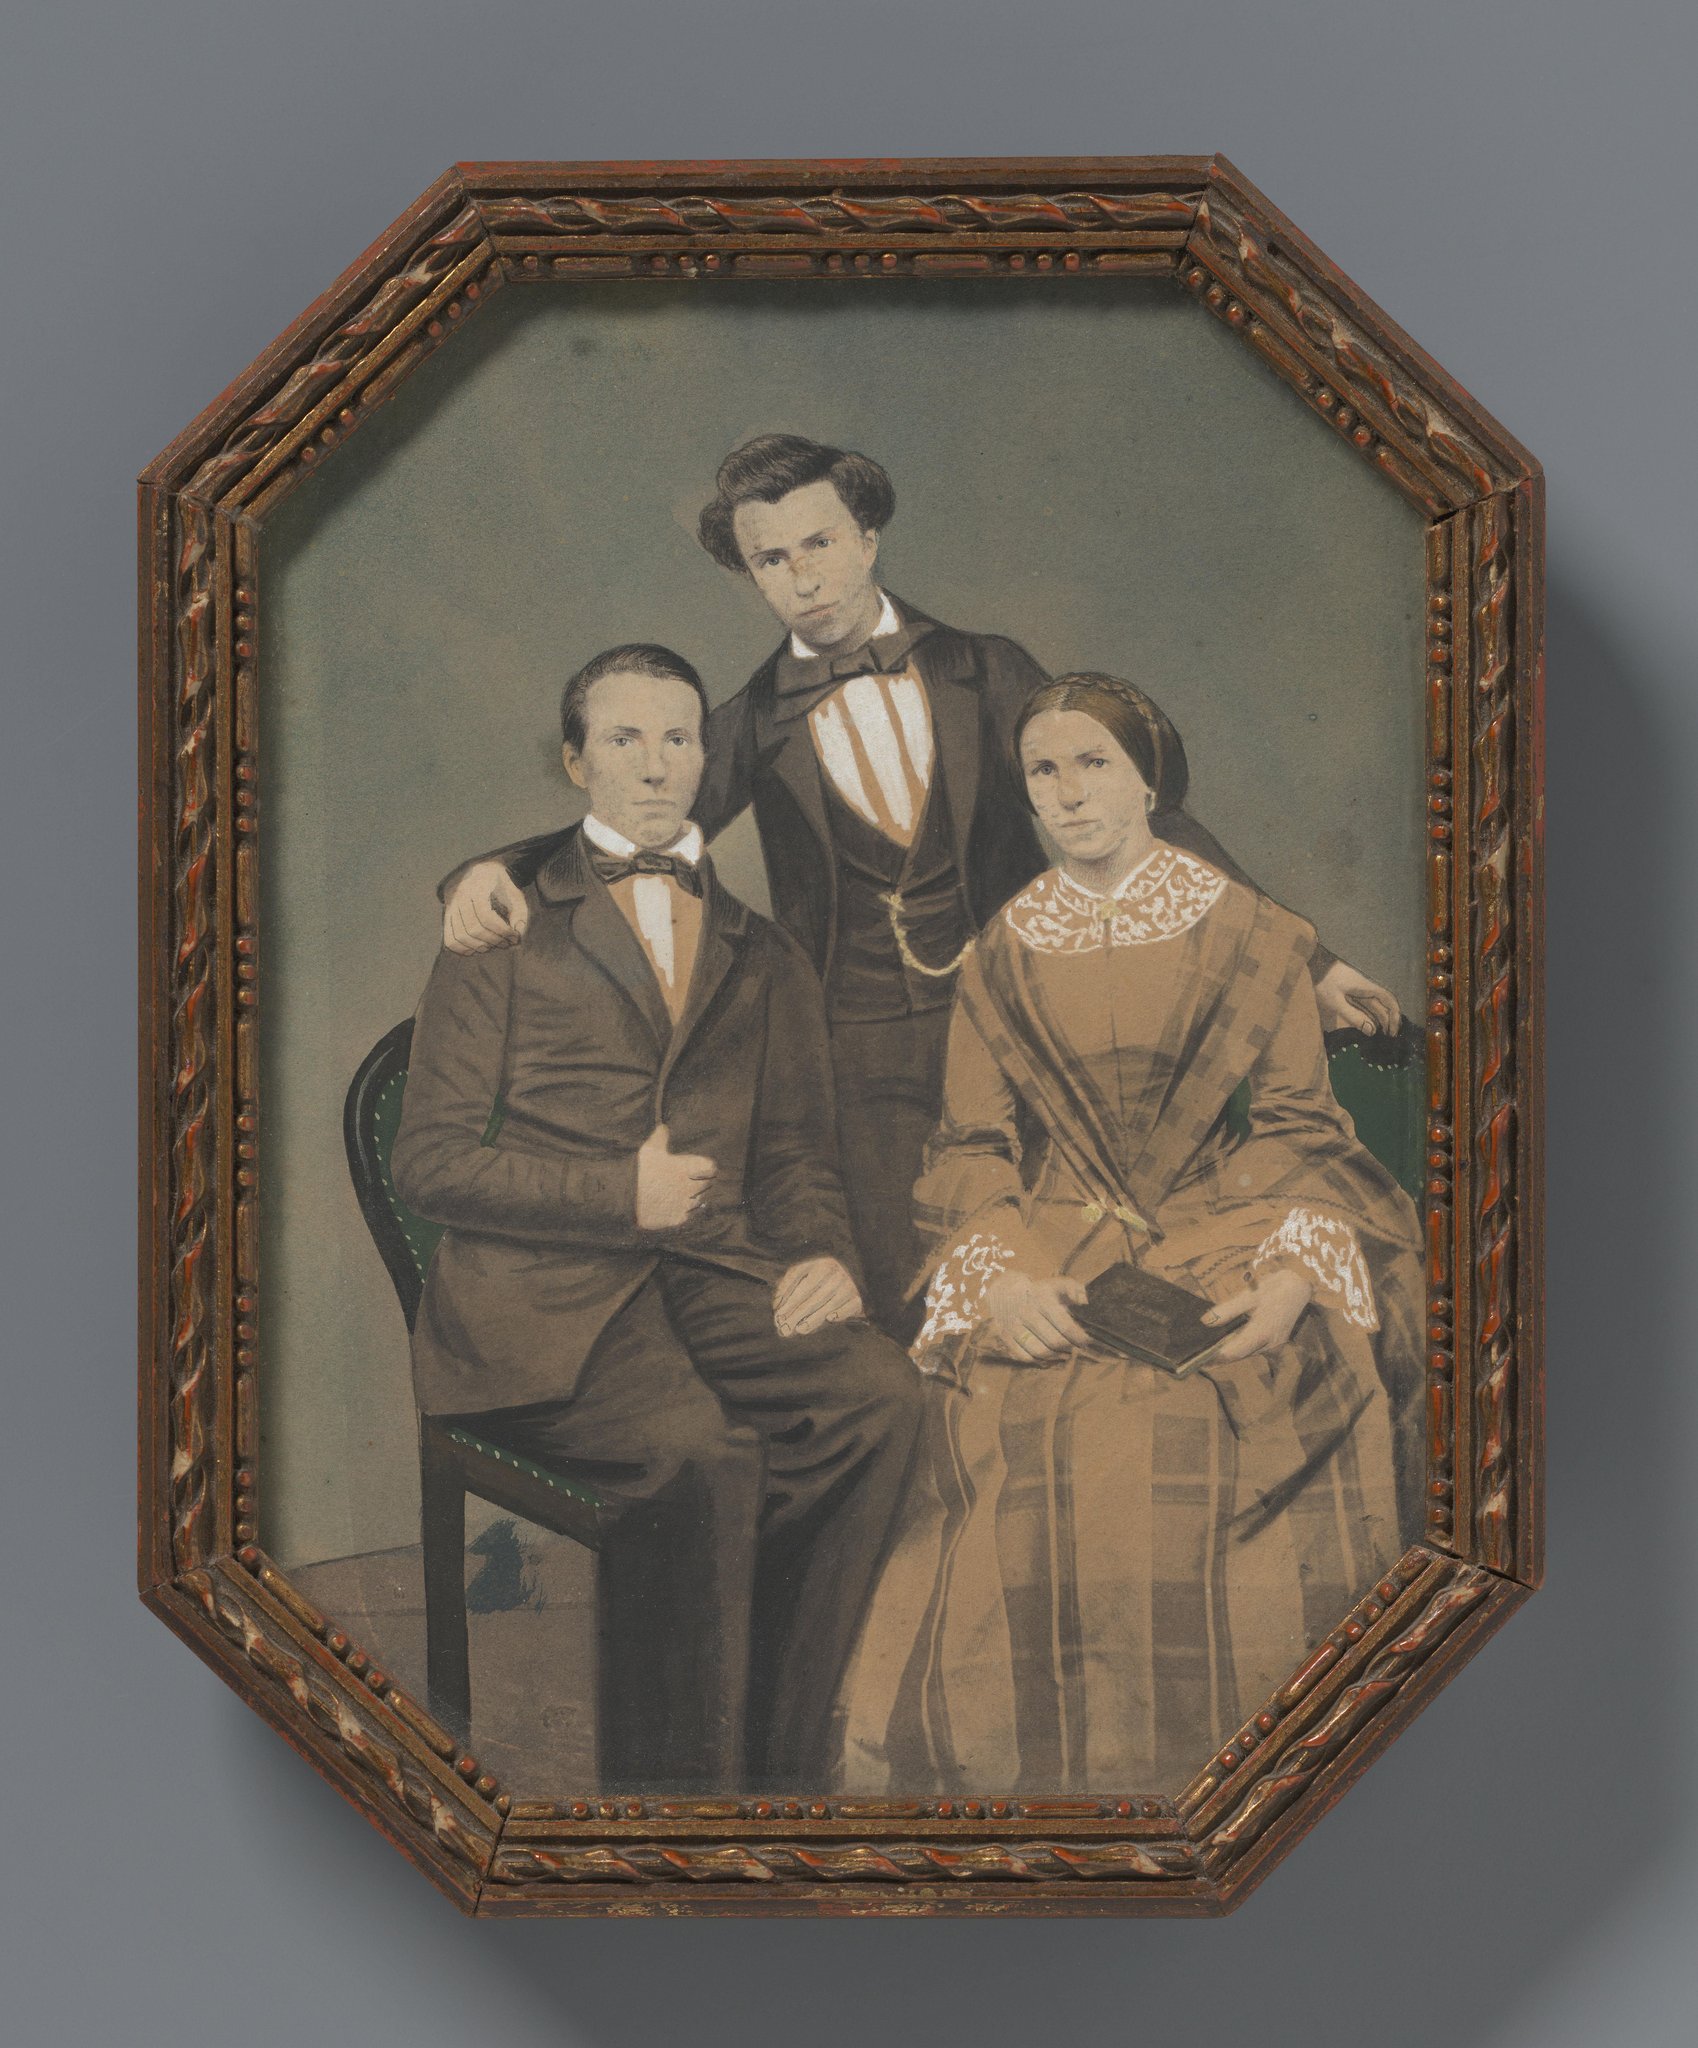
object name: photograph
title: Portret van Frans, Pieter en Cornelia van den Berg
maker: henri pronk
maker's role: fotograaf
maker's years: 1813-1893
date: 1855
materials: cardboard, metal, paper, wood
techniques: photographie peinte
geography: rotterdam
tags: rotterdam, delft, historical persons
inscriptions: inscription: ‘Kinderen/ [.....]/ F.J. 1833-1892’, number: ‘III’, inscription: ‘Vier foto's van het gezin van mijn overgroot-/ ouders P.F. van den Berg - E.M. Th. van Kerckhoff/ gemaakt in 1855 te Rotterdam ten behoeve van/ hun naar Batavia vertrokken oudste zoon Nor-/ bertus Petrus (mijn grootvader), geb. Rotterdam/ 5 Nov. 1831, overl. Amsterdam 8 Jan. 1917./ KINDEREN:/ Frans: Franciscus Johannes/ geb. Rotterdam 18 juli 1833/ overl. Hilversum 30 Mrt. 1892/ Peter: Petrus Johannes Wilhelmus/ geb. Rotterdam 19 Oct. 1835/ overl. Rotterdam 26 Mei 1892/ Cornelia: Cornelia Theresia Caroline/ geb. Rotterdam 8 Dec. 1837/ overl. Delft 3 Oct. 1907’, inscription: ‘FIRMA J.S. FETTER & CO/ VIJZELSTRAAT/ 136/ AMSTERDAM’